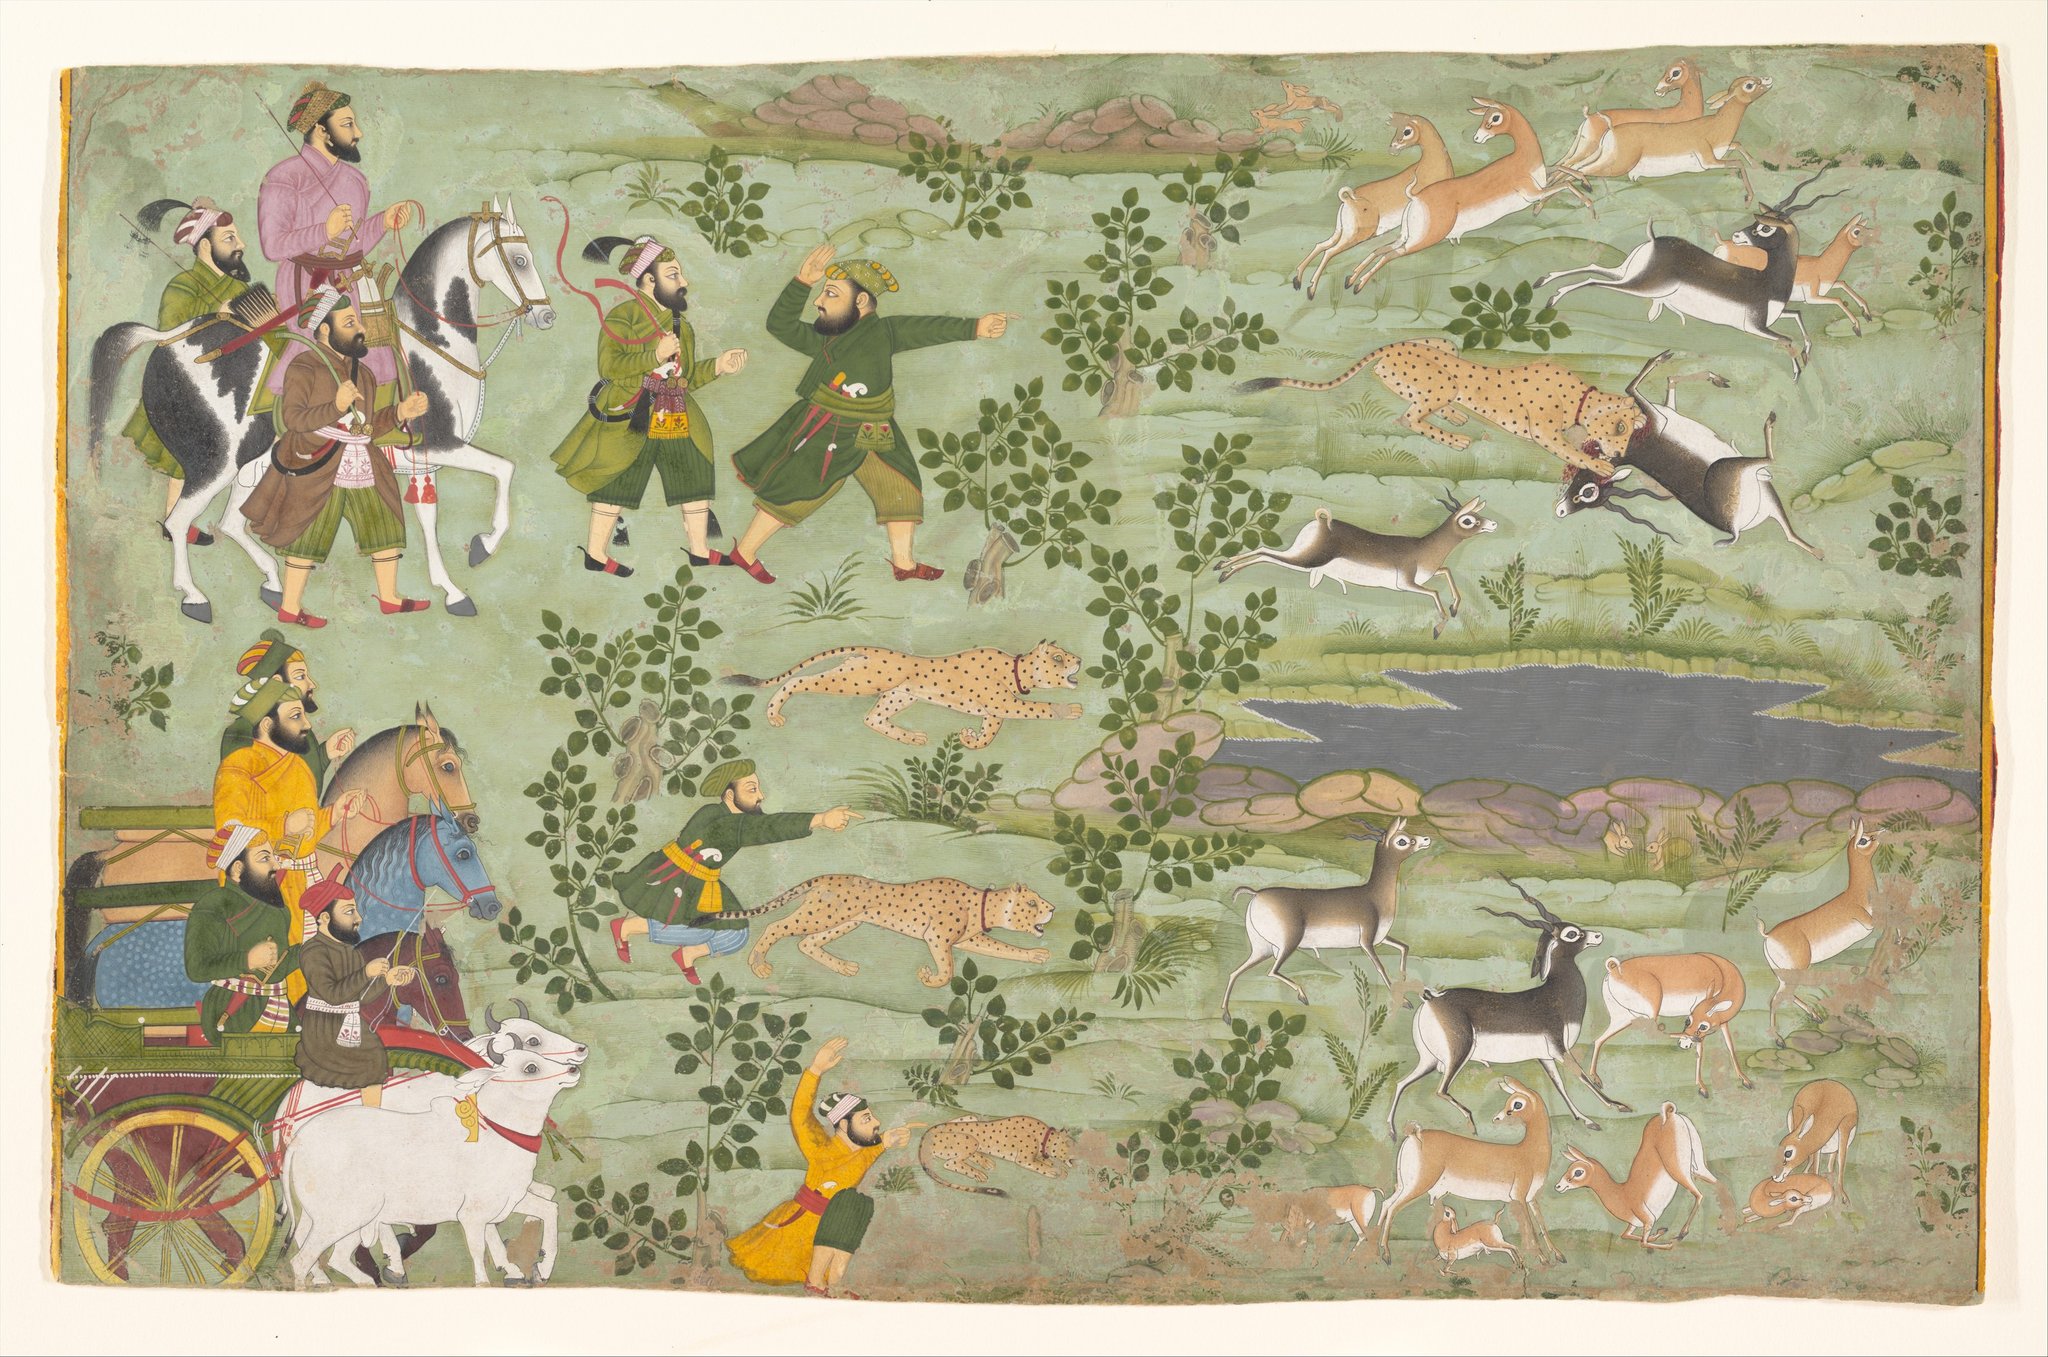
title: Shah Jahan Hunting Blackbuck with Trained Cheetahs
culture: western indian, rajasthan, udaipur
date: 1710-1715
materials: gold, ink, paper, watercolor